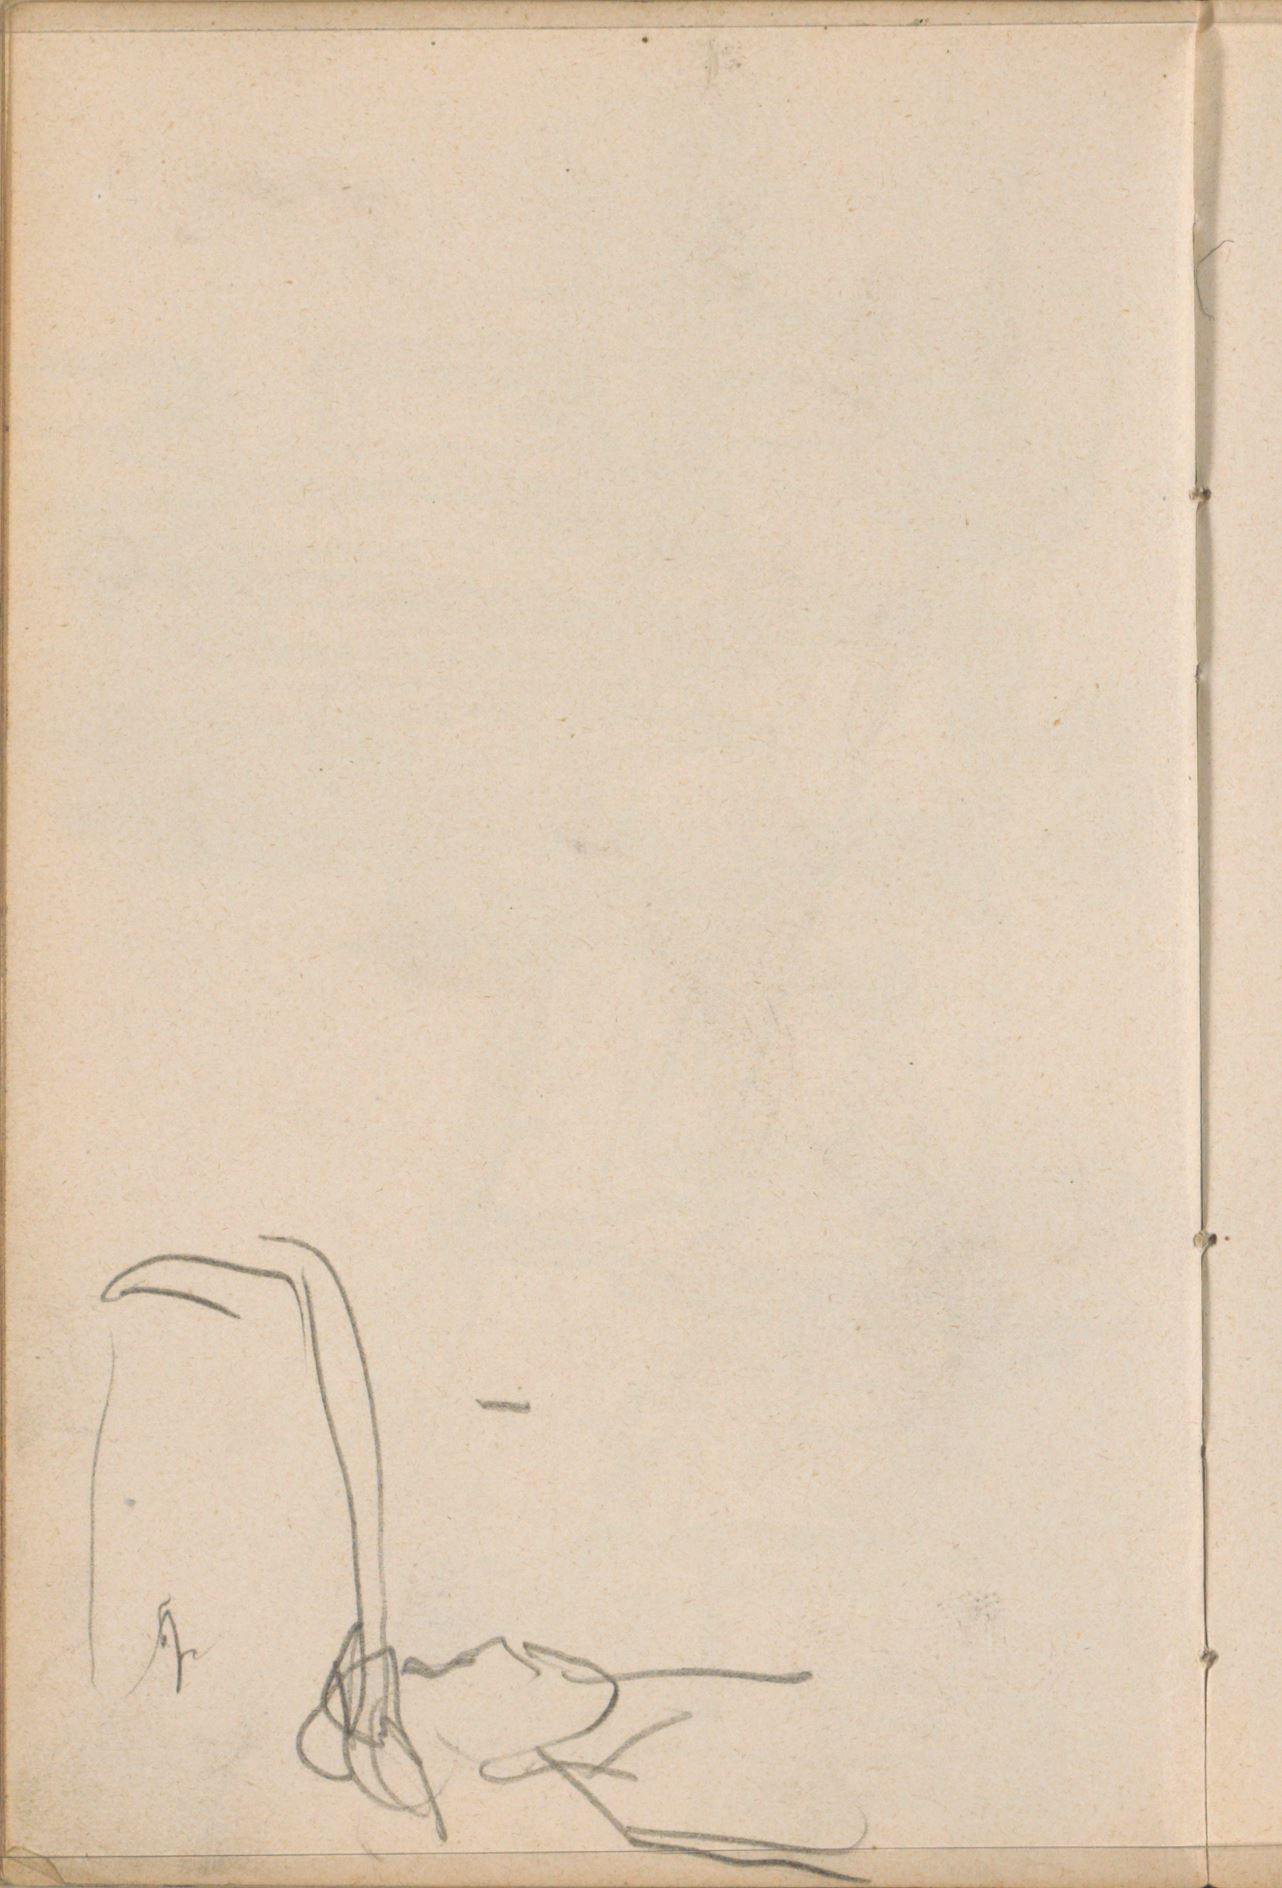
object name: sketchbook leaf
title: Figuurstudie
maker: george hendrik breitner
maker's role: draughtsman, painter, print maker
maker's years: 1857-1923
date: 1902-1914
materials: paper, pencil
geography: amsterdam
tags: human being, man in general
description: Figuurstudie. Pagina 29 uit een schetsboek met 46 bladen vervaardigd te Noord-Holland en Utrecht.